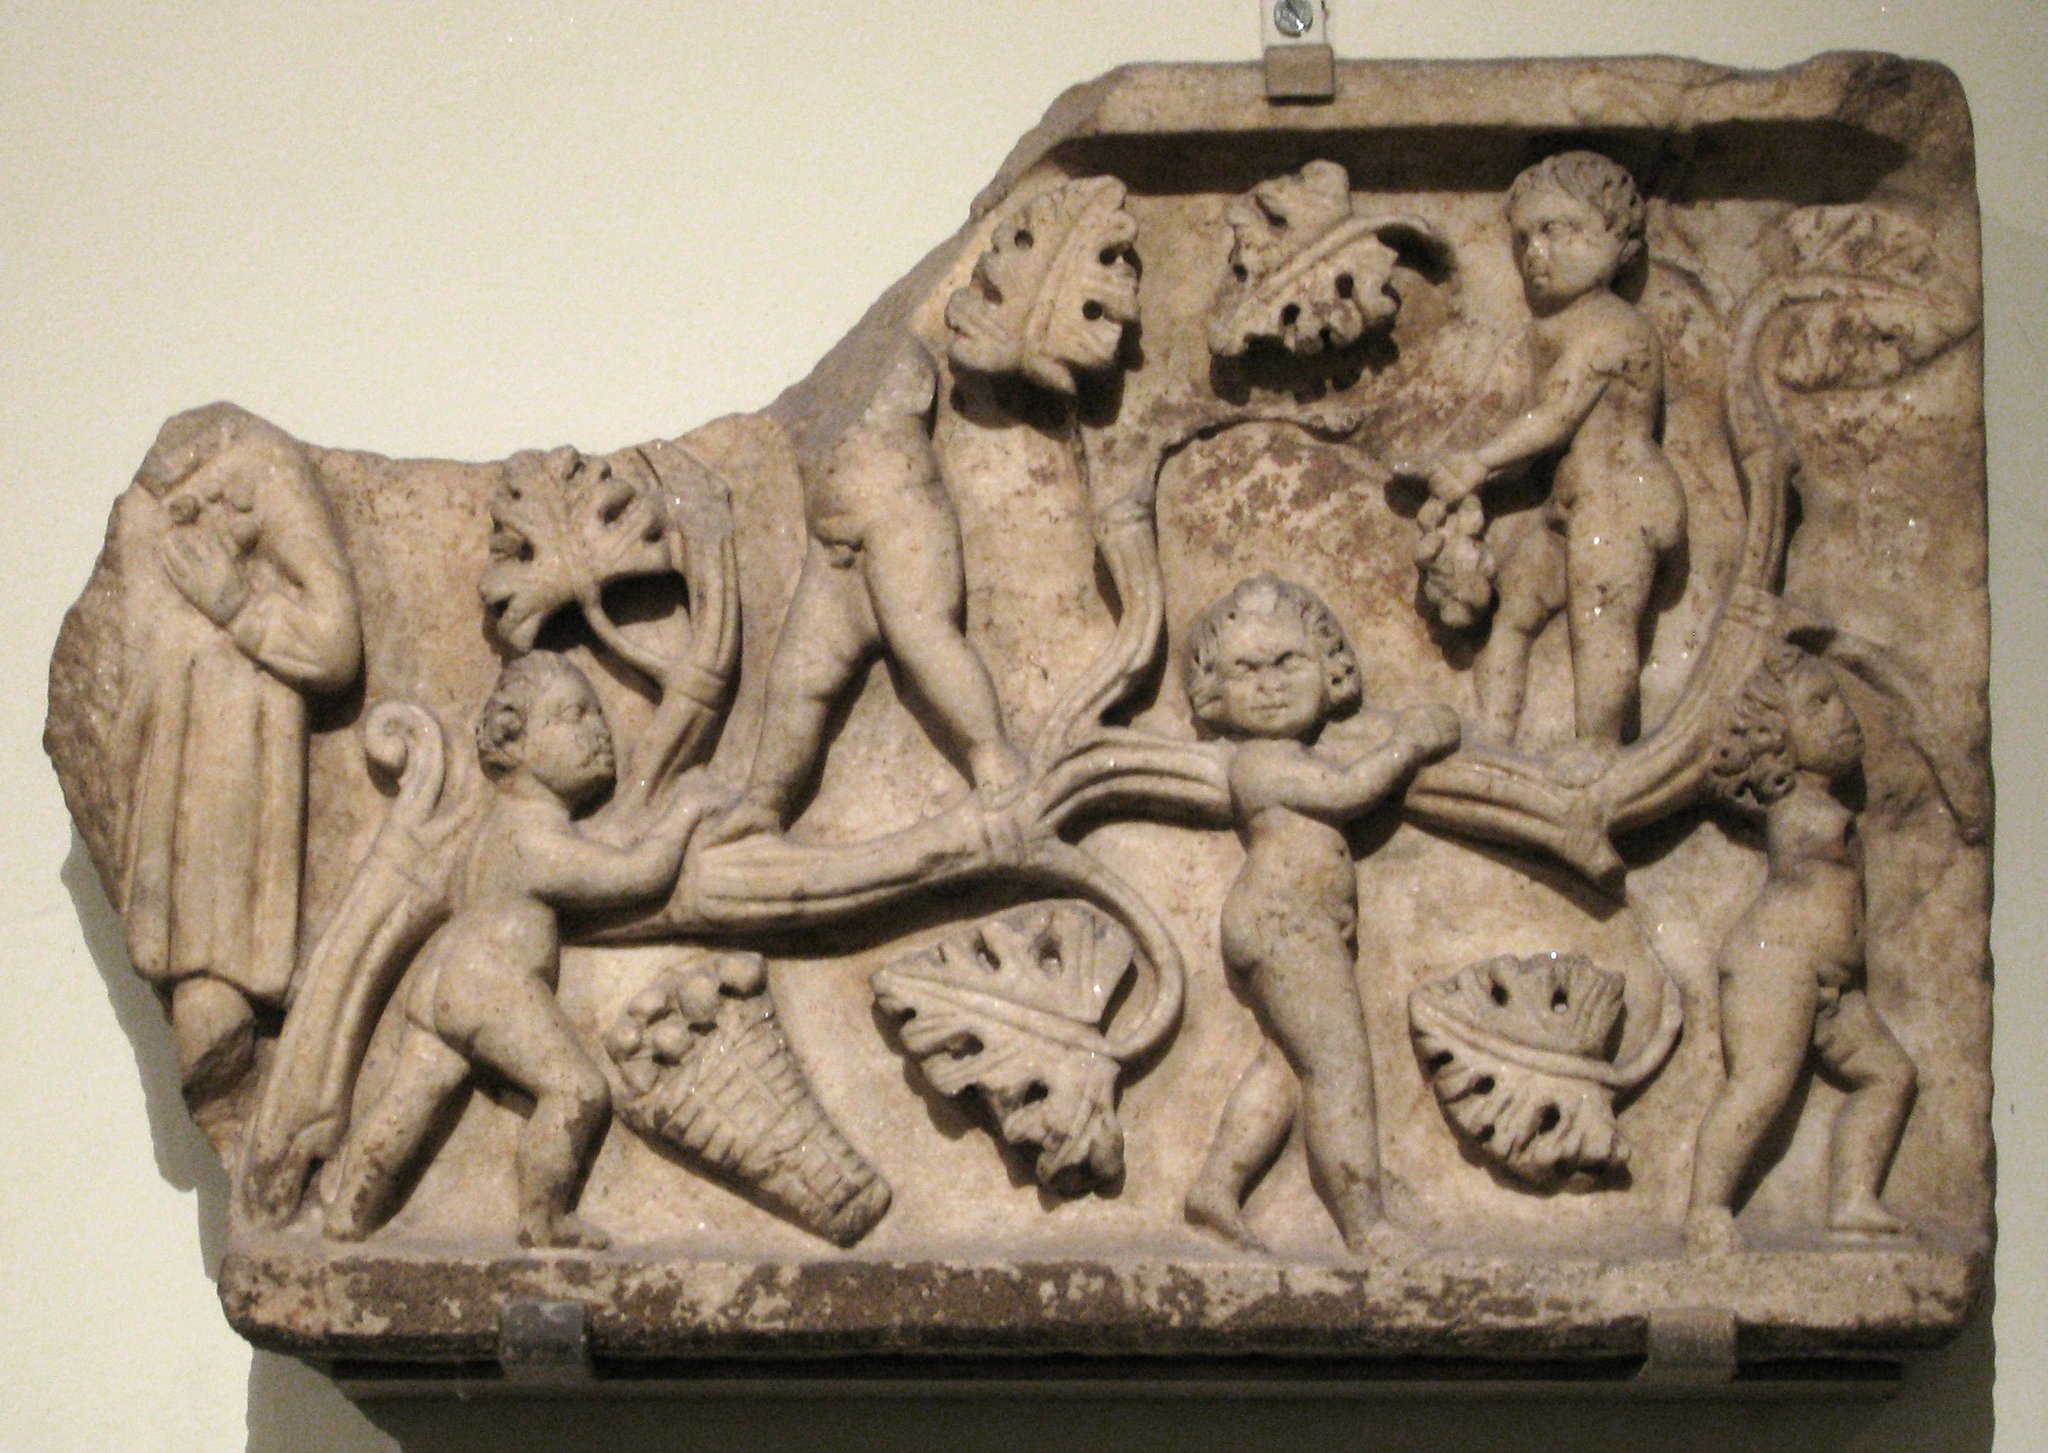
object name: relief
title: Fragment of a Sarcophagus with Putti in a Grapevine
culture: roman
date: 201-400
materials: marble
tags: putti,vines